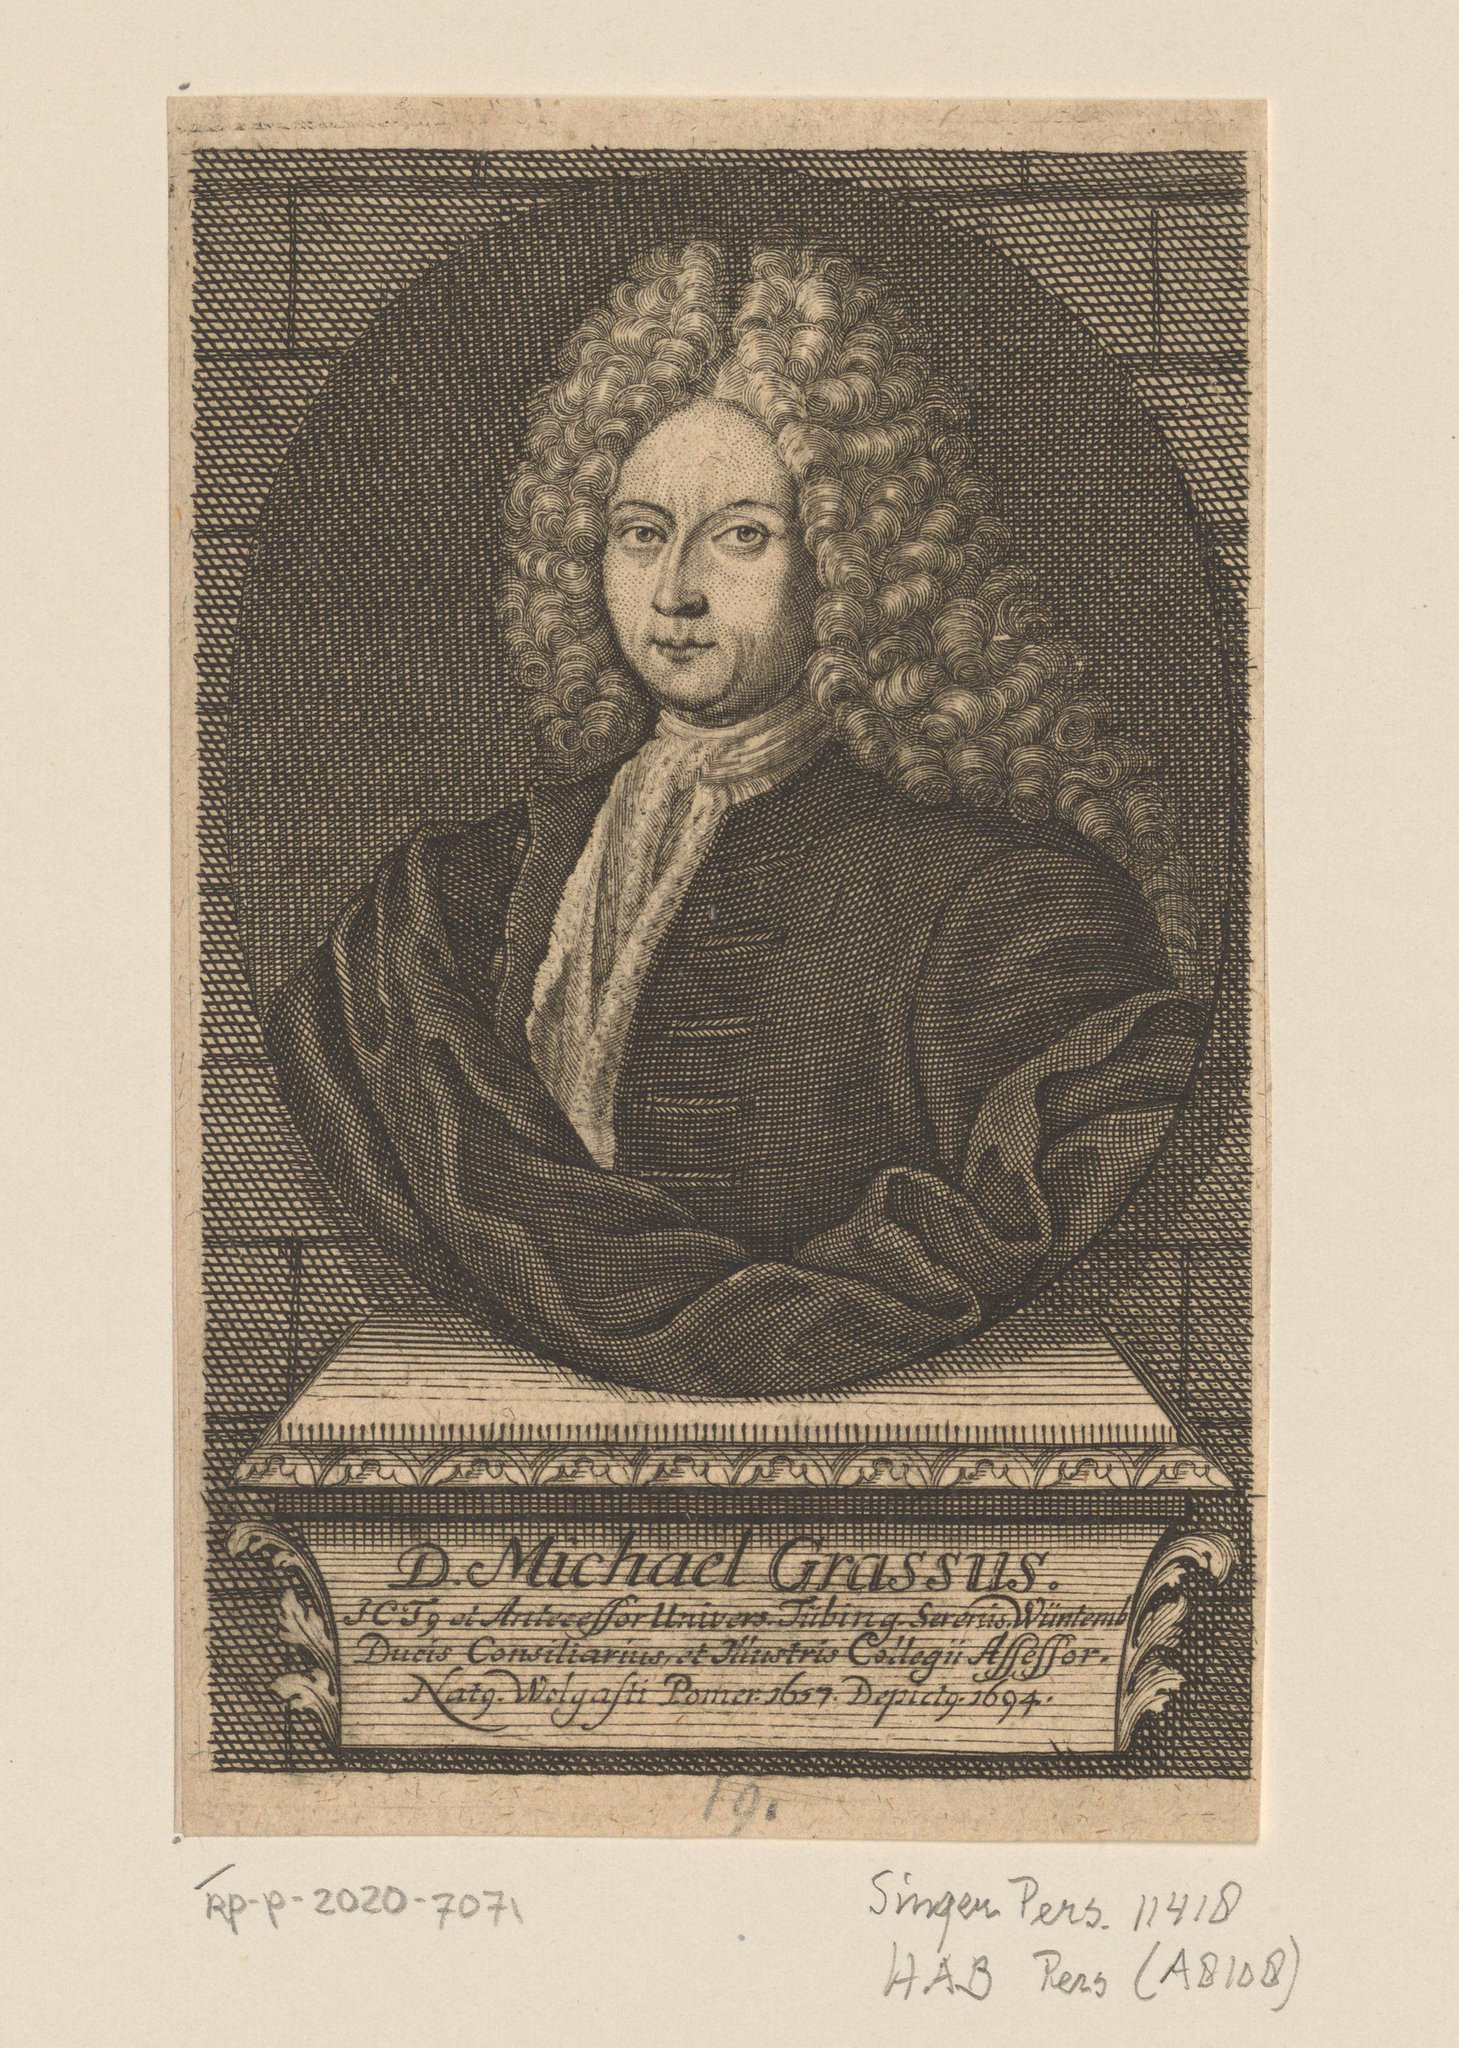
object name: print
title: Portret van Michael Grass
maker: johann georg mentzel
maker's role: print maker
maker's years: 1677-1743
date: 1694-1743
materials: paper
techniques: engraving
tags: theologian, historical persons, portrait of a writer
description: Tekst in het Latijn in de ondermarge en in de omlijsting.